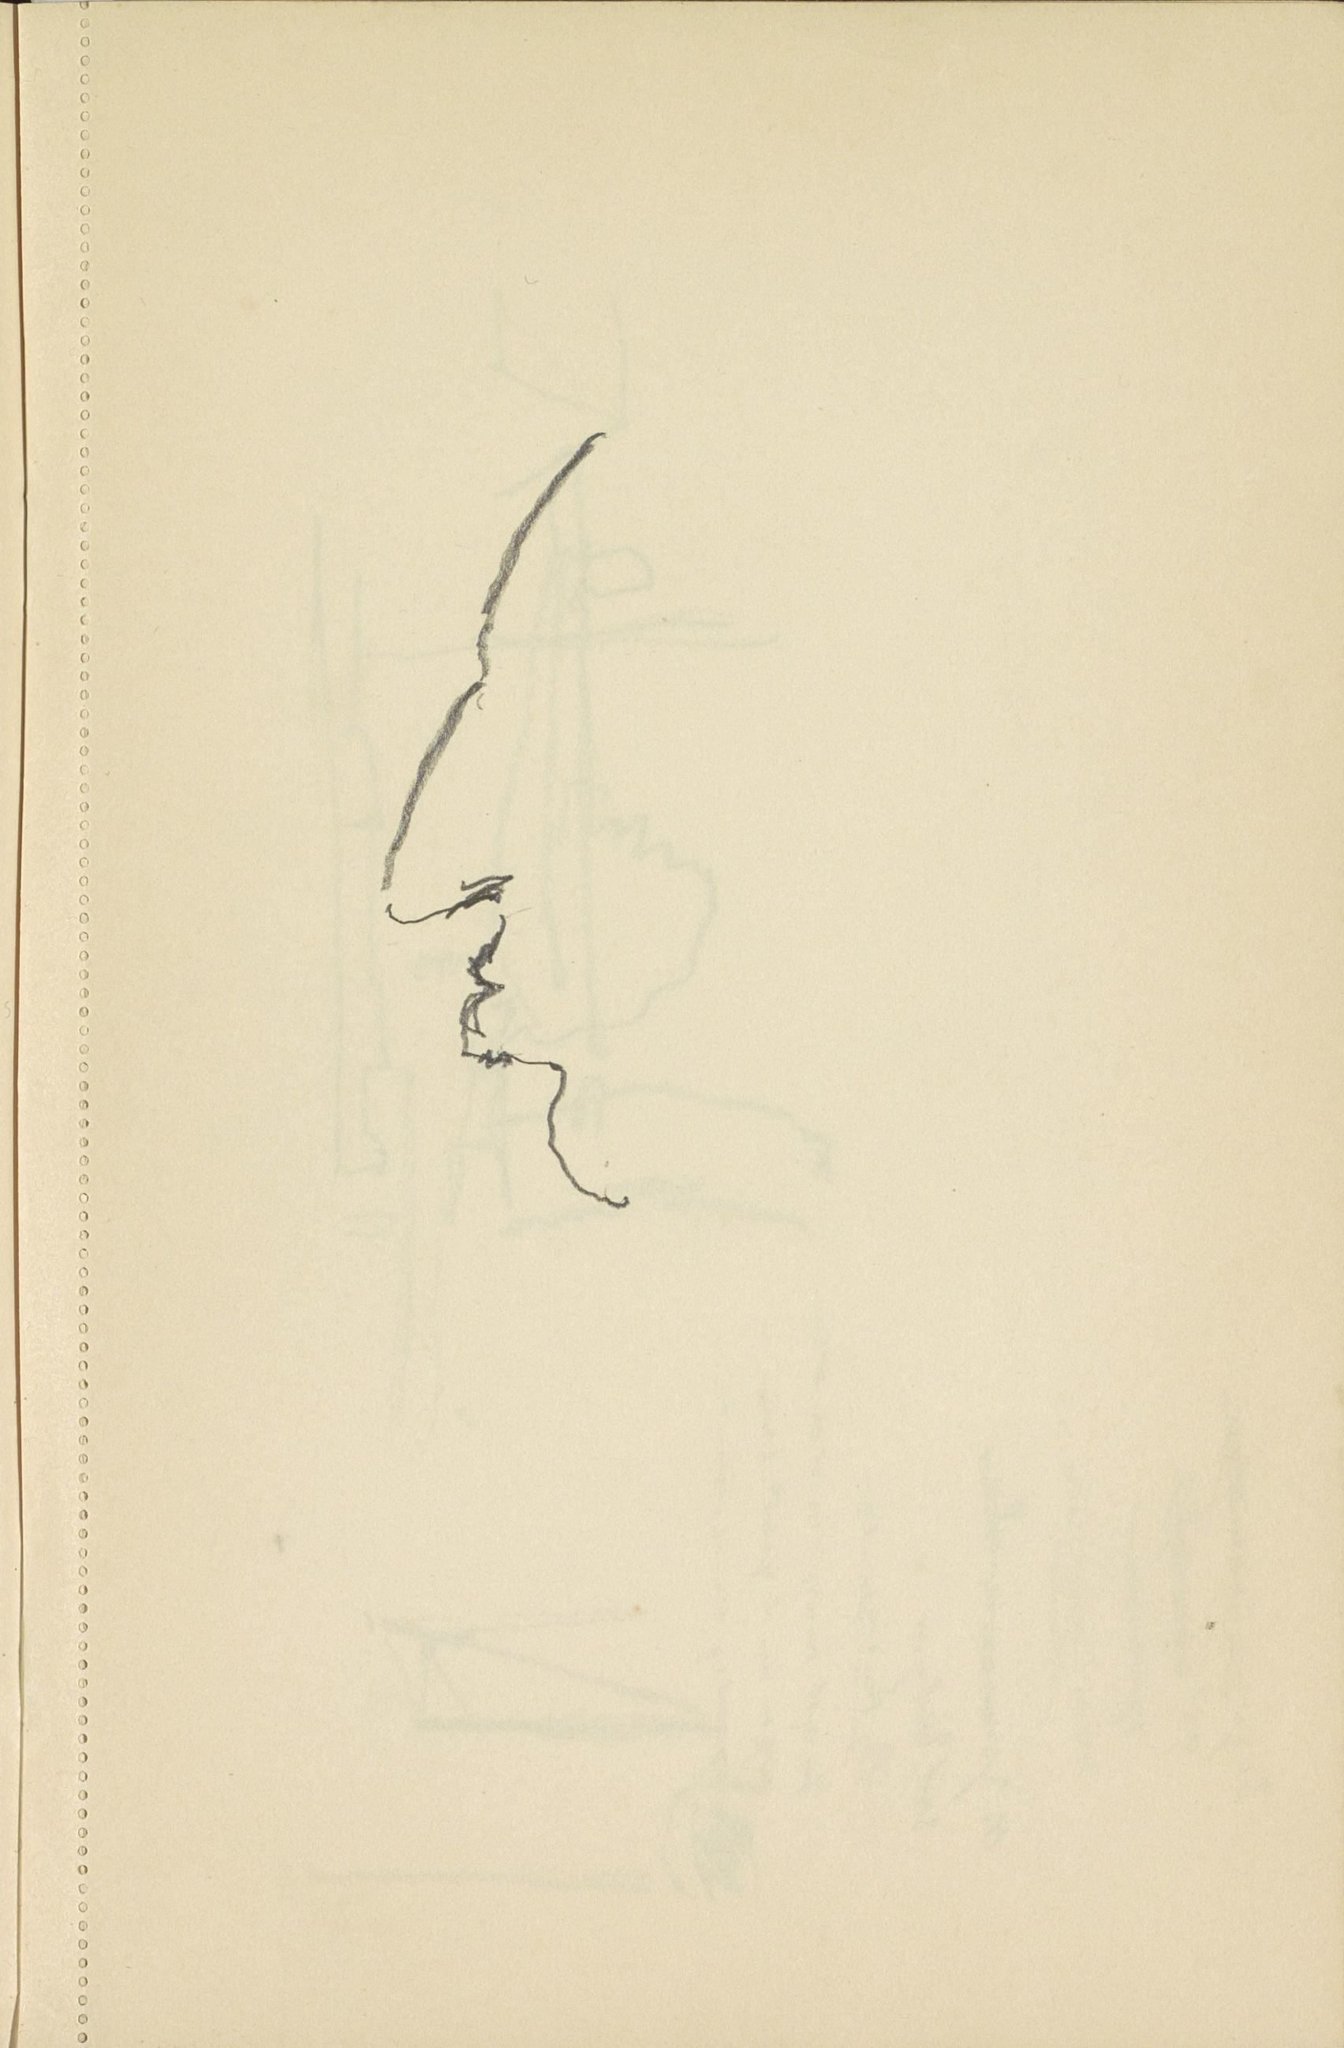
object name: sketchbook leaf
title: Gezicht van een man, in profiel naar links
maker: cornelis vreedenburgh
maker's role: draughtsman, print maker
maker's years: 1880-1946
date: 1890-1946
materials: paper, pencil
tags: face (+ left side visible; left - (l. hand, l. foot, etc.))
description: Blad 48 recto uit een schetsboek met 73 bladen.